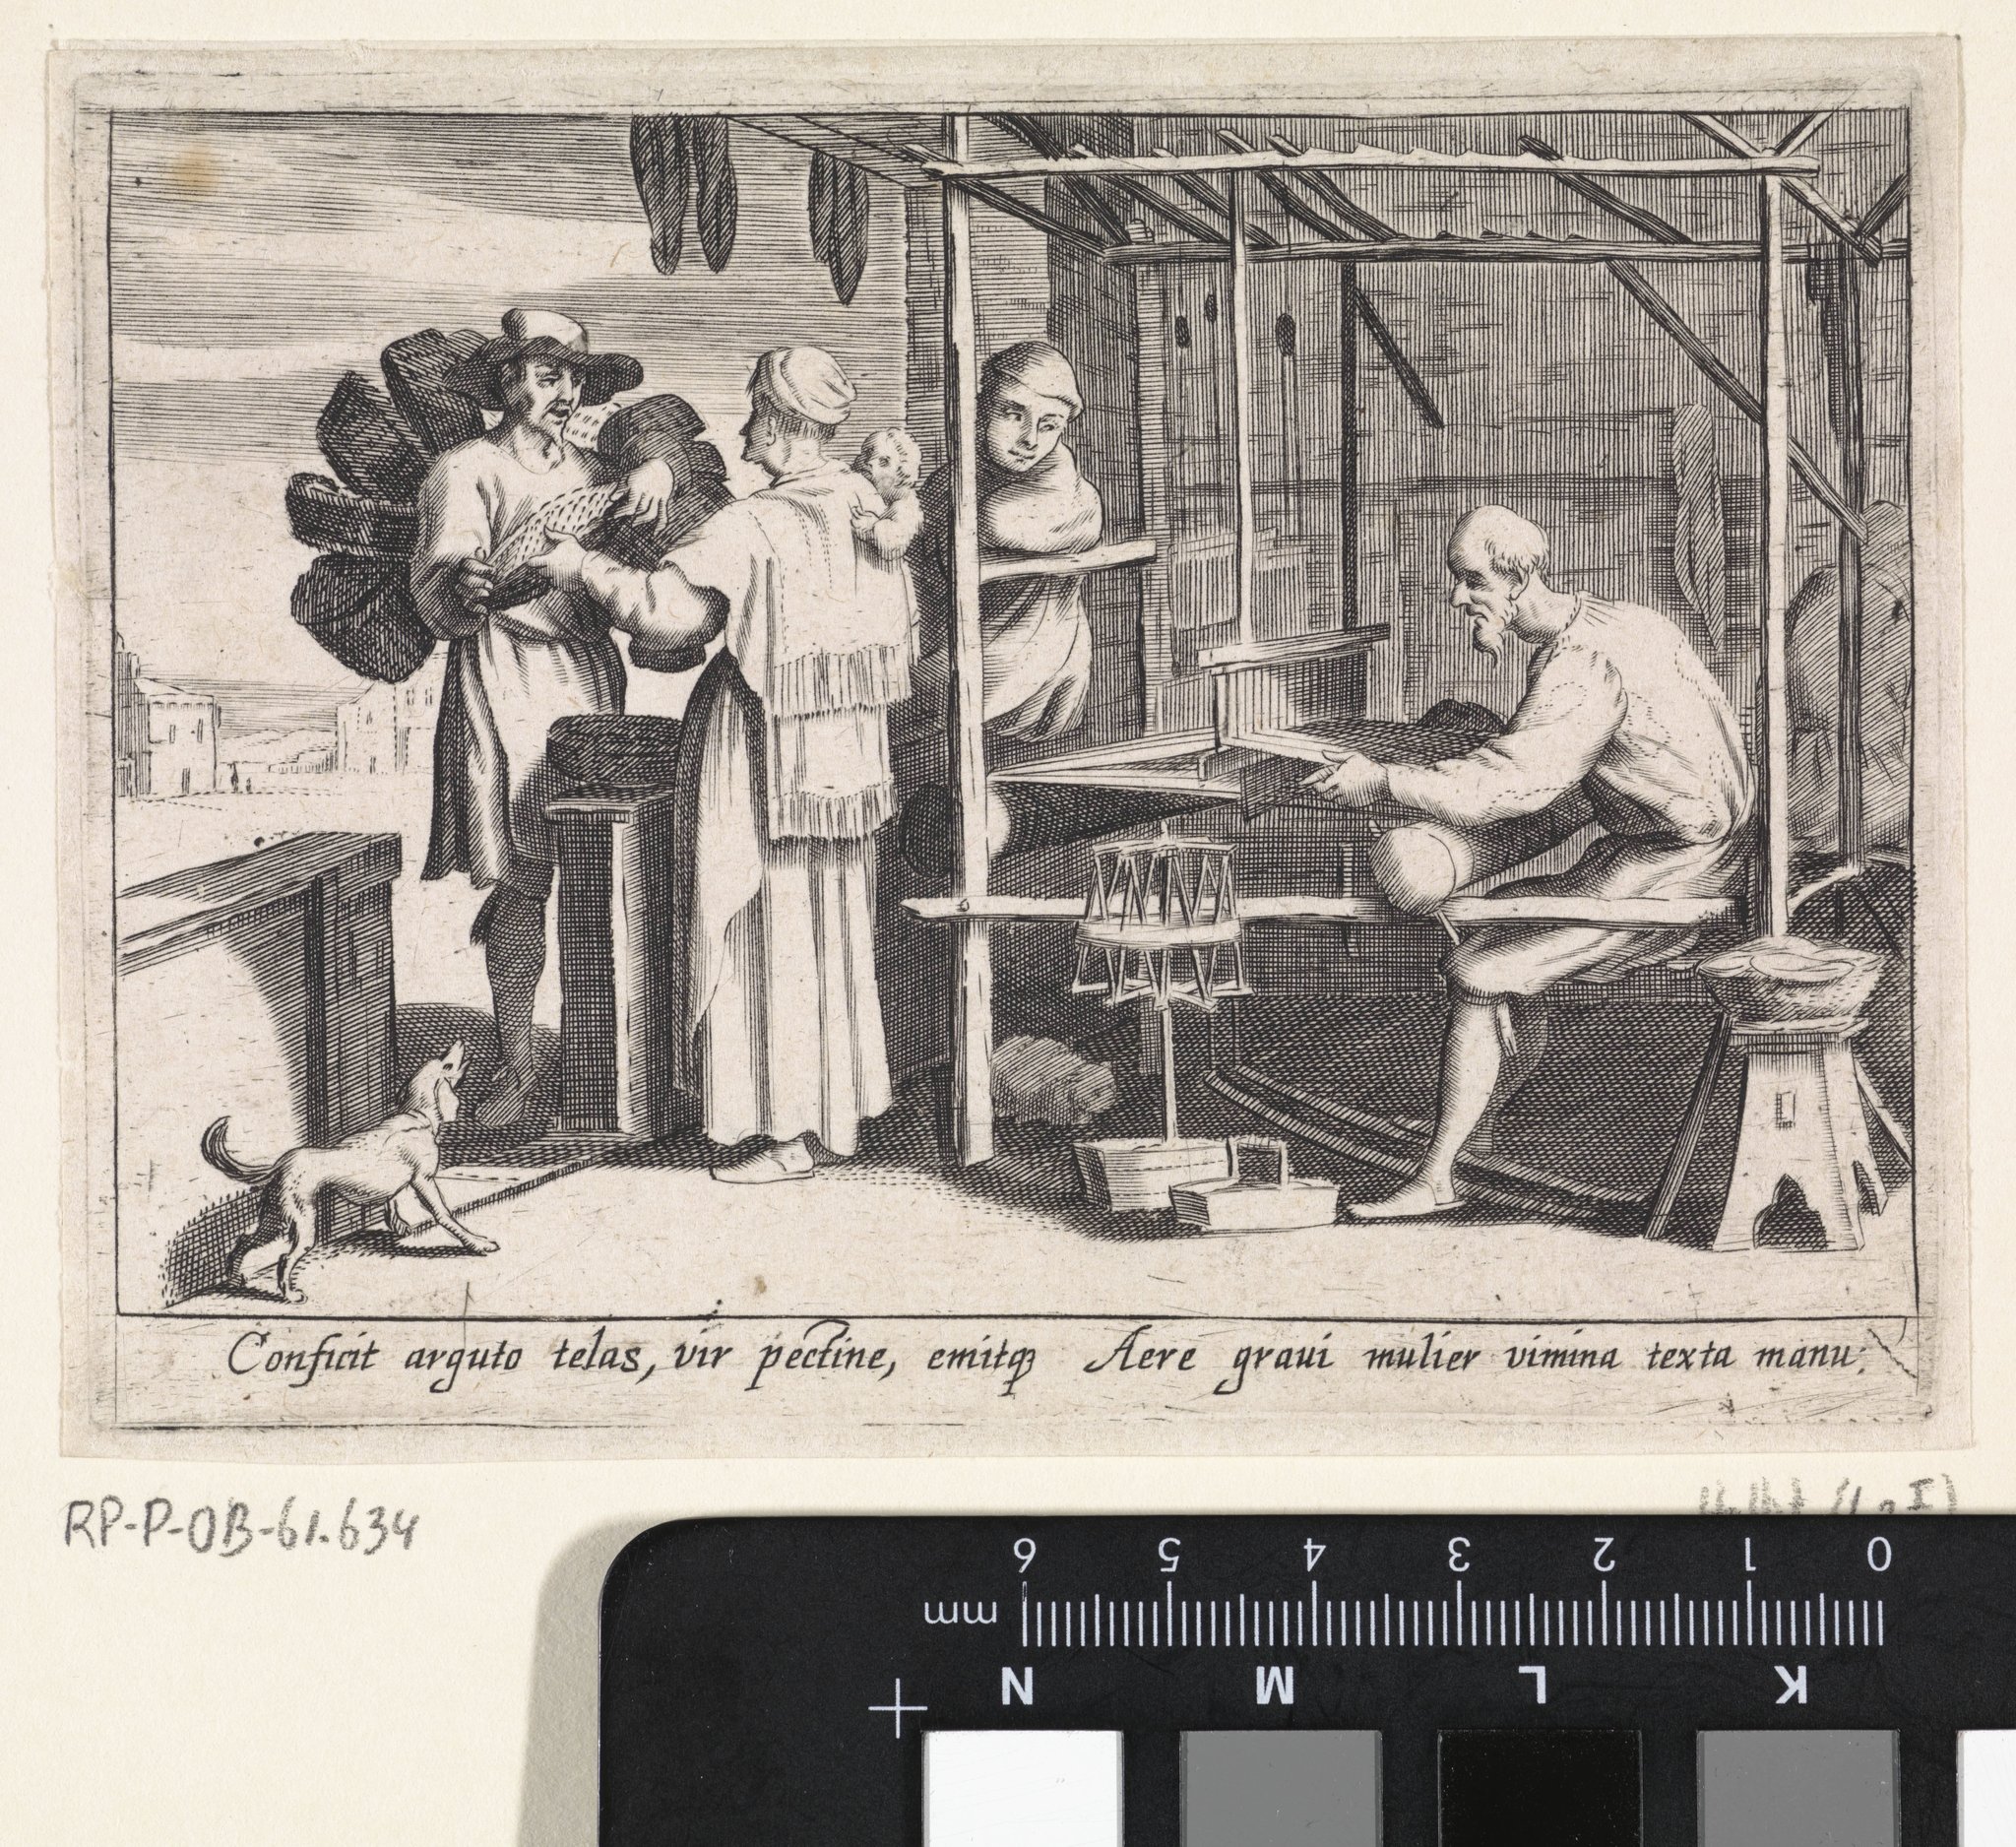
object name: print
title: Italiaanse handwerkslieden en verkopers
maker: Anonymous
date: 1613-1667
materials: paper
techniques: engraving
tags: container made of plant material other than wood: basket, weaving, merchant, salesman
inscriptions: collector's mark: Lugt 240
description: Een wever is aan het werk aan zijn weefgetouw. Een mandenverkoper probeert zijn waar te verkopen aan de vrouw van de wever. In de marge een onderschrift in het Latijn.